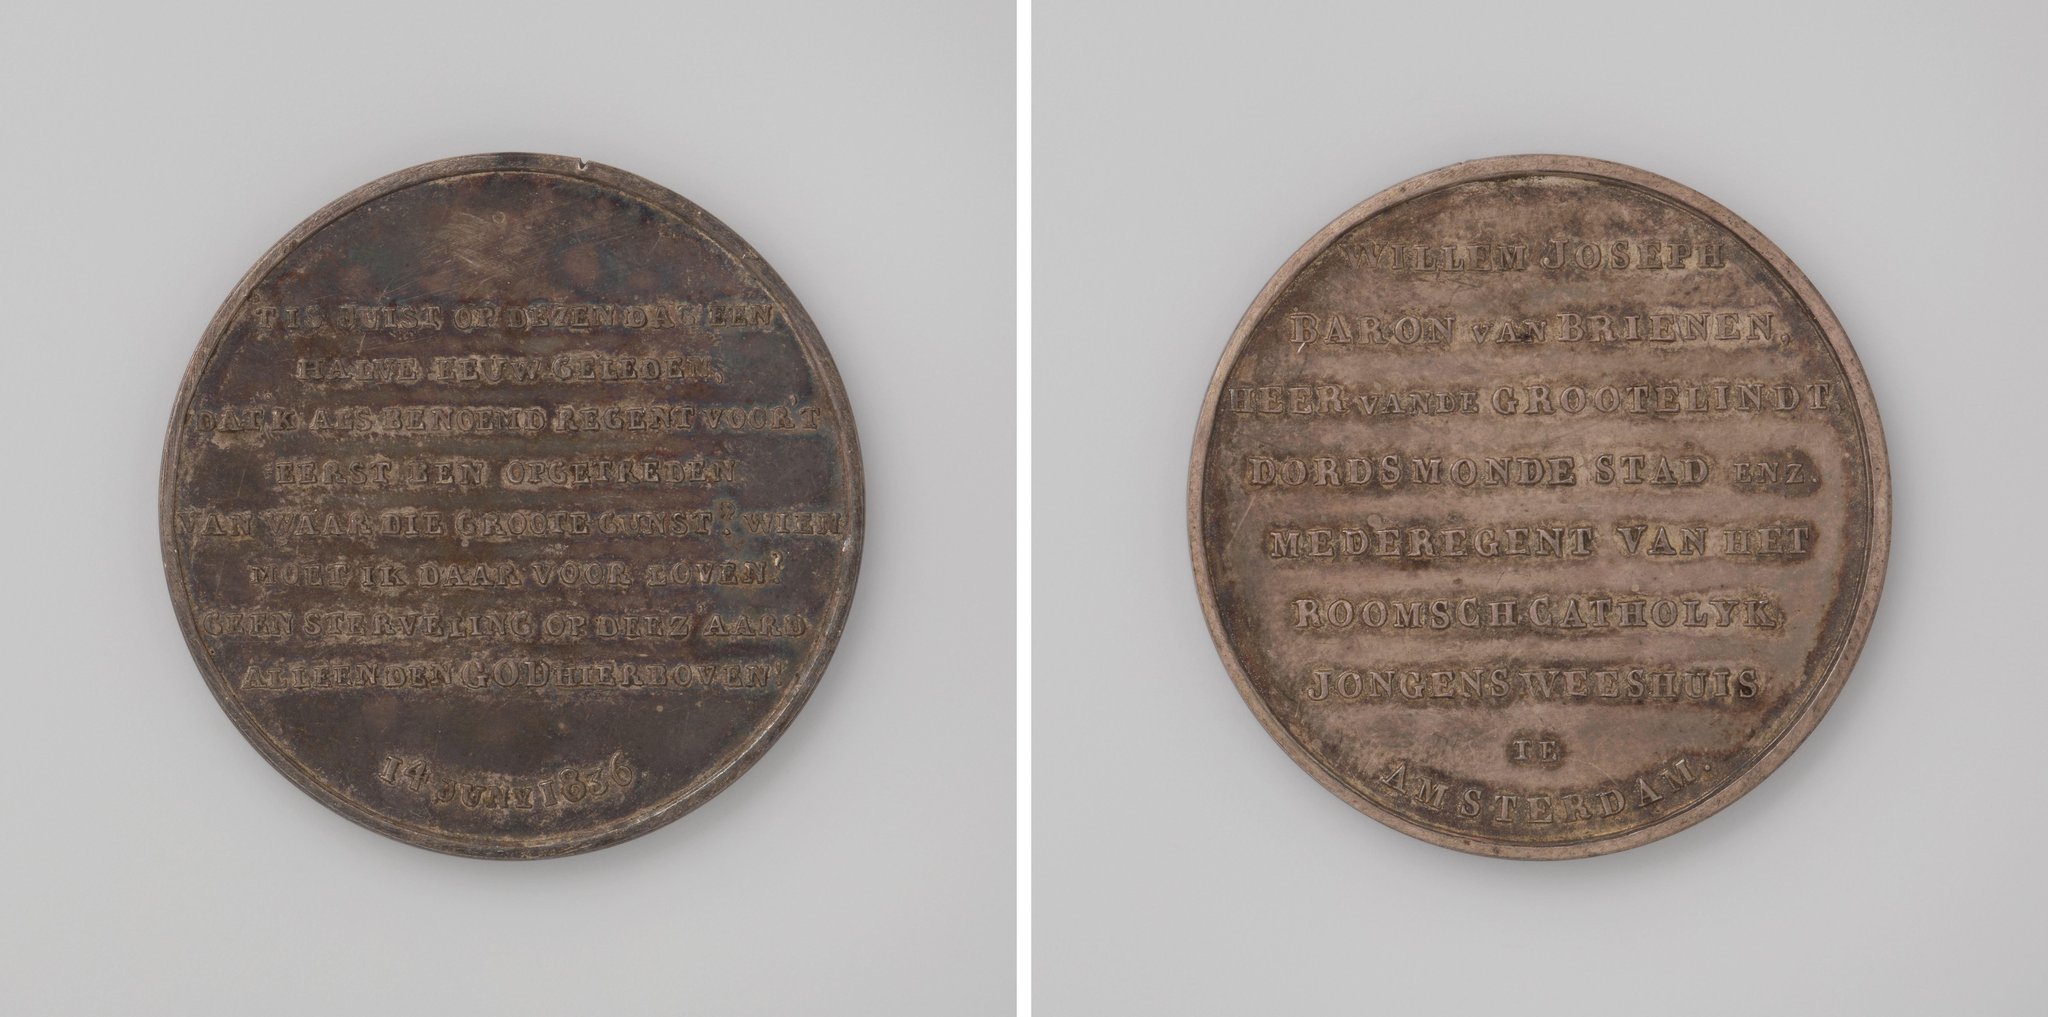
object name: history medal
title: Willem Joseph, baron van Brienen, vijftig jaar regent van het Rooms-katholiek weeshuis te Amsterdam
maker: Anonymous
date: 1836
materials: silver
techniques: striking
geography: netherlands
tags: amsterdam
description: Zilveren penning. Voorzijde: opschrift. Keerzijde: opschrift